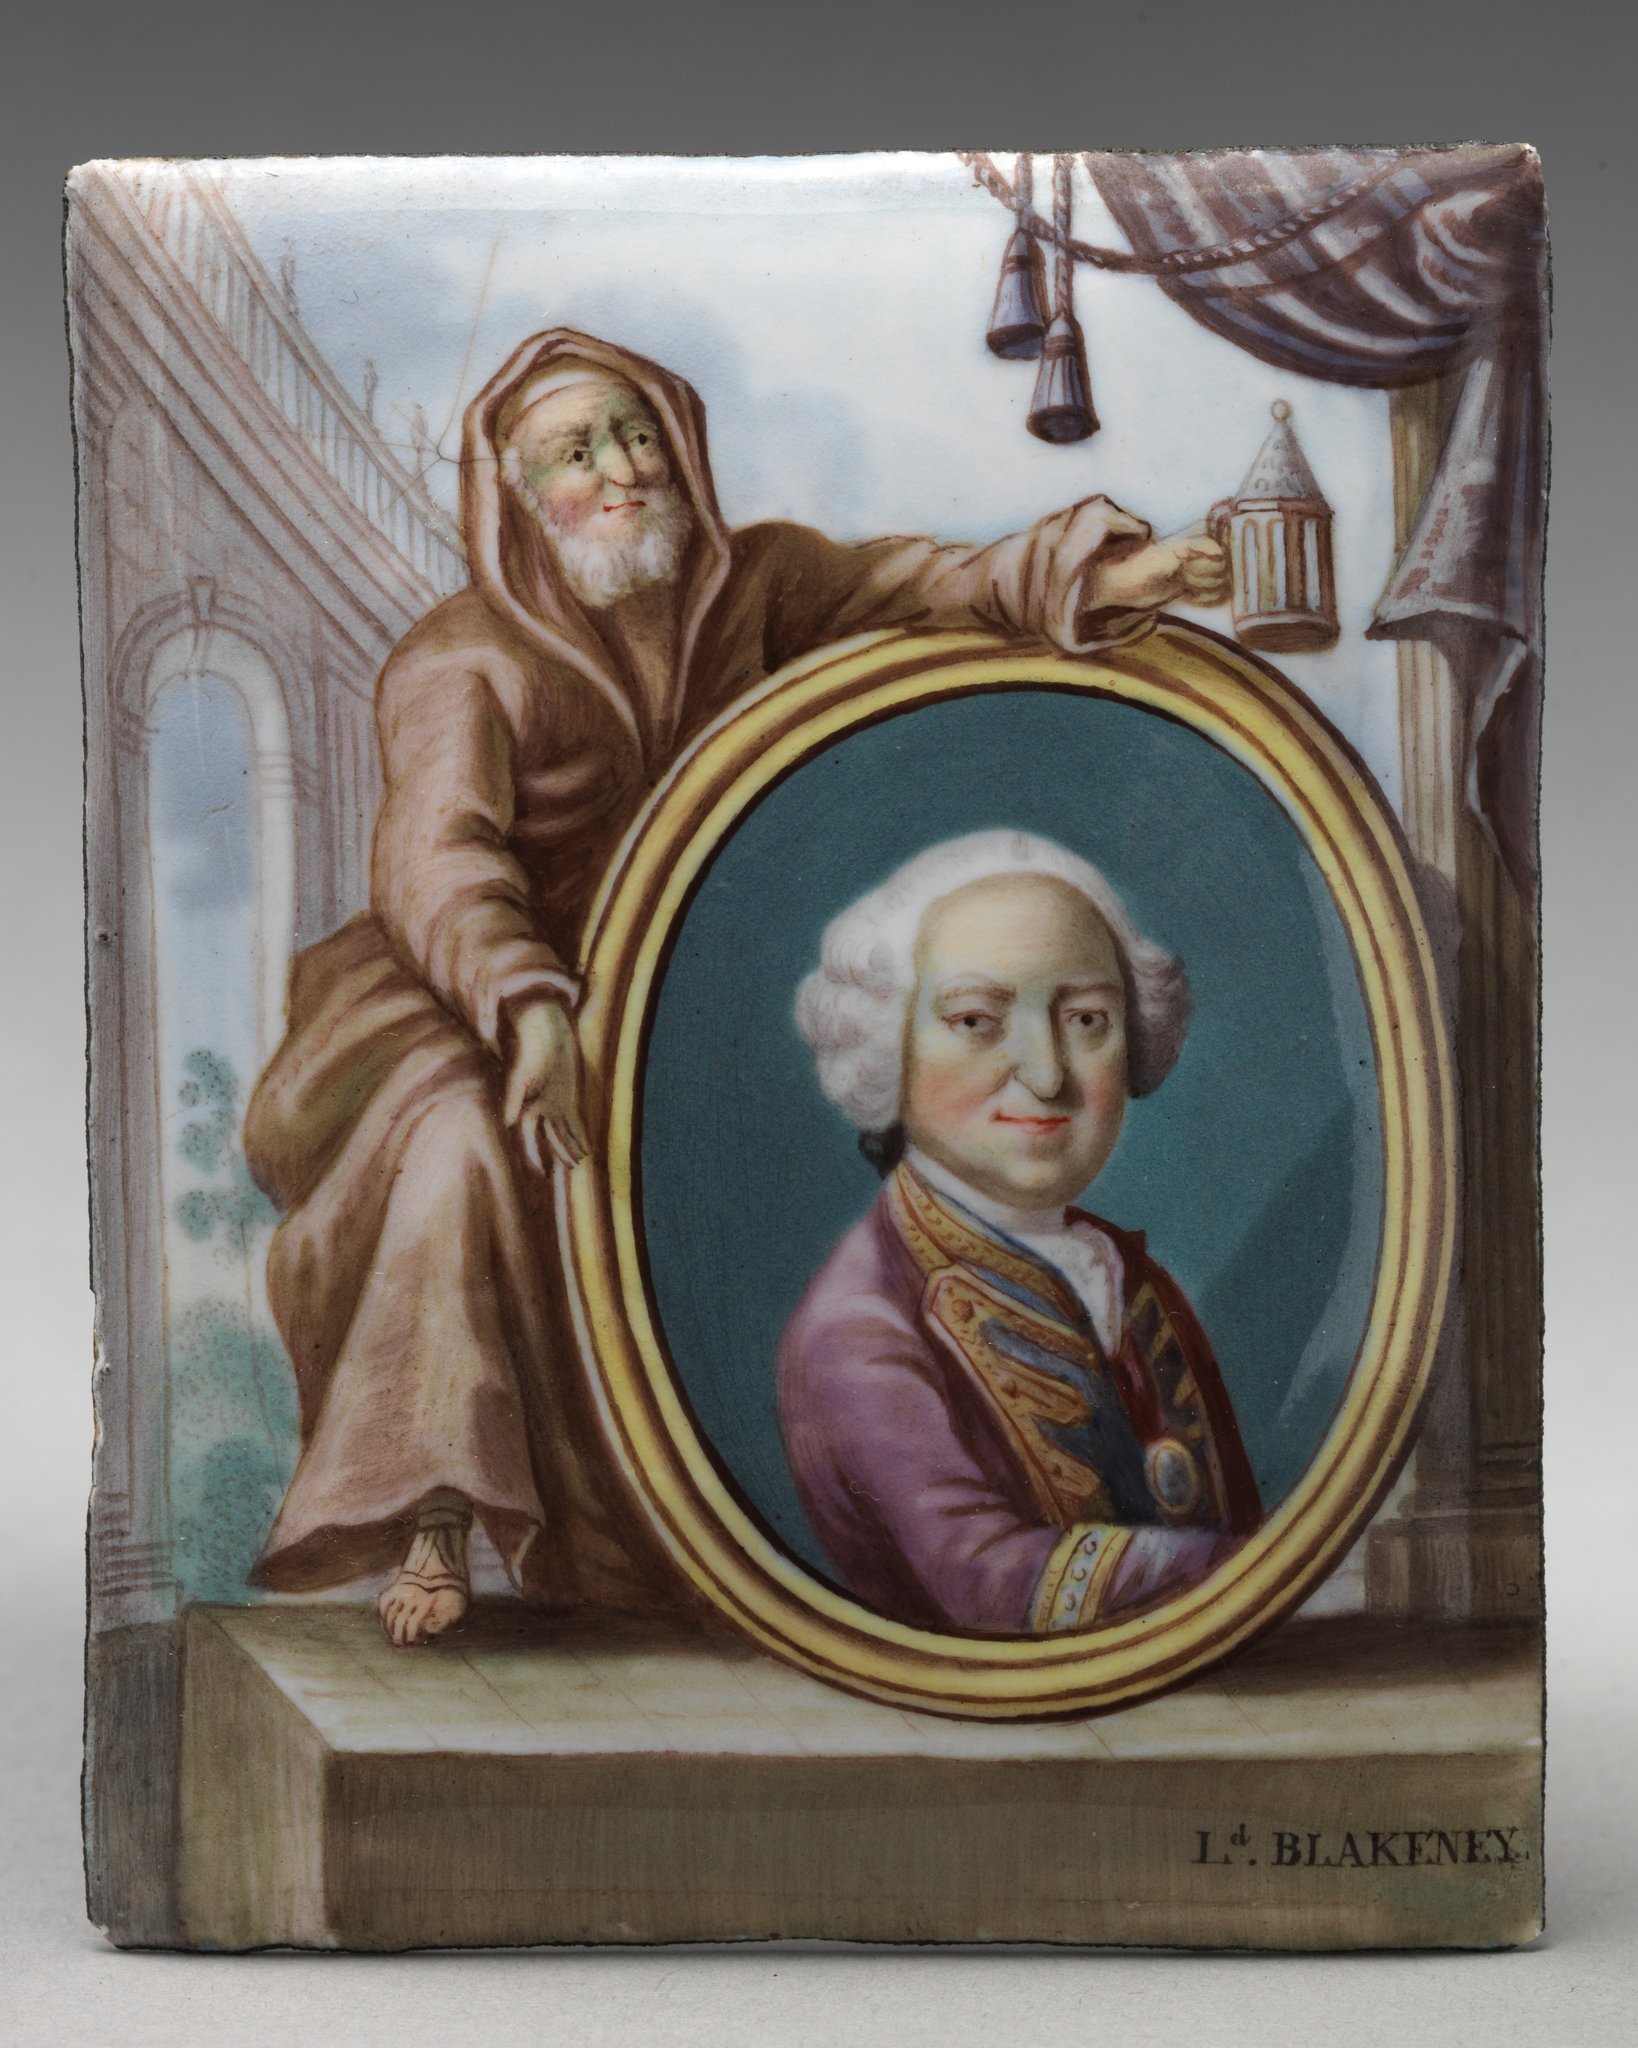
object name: plaque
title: Lord William Blakeney (1692–1761)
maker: james mcardell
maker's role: engraver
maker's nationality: irish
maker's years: 1728-1765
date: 1756-1761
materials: copper, enamel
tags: men,portraits